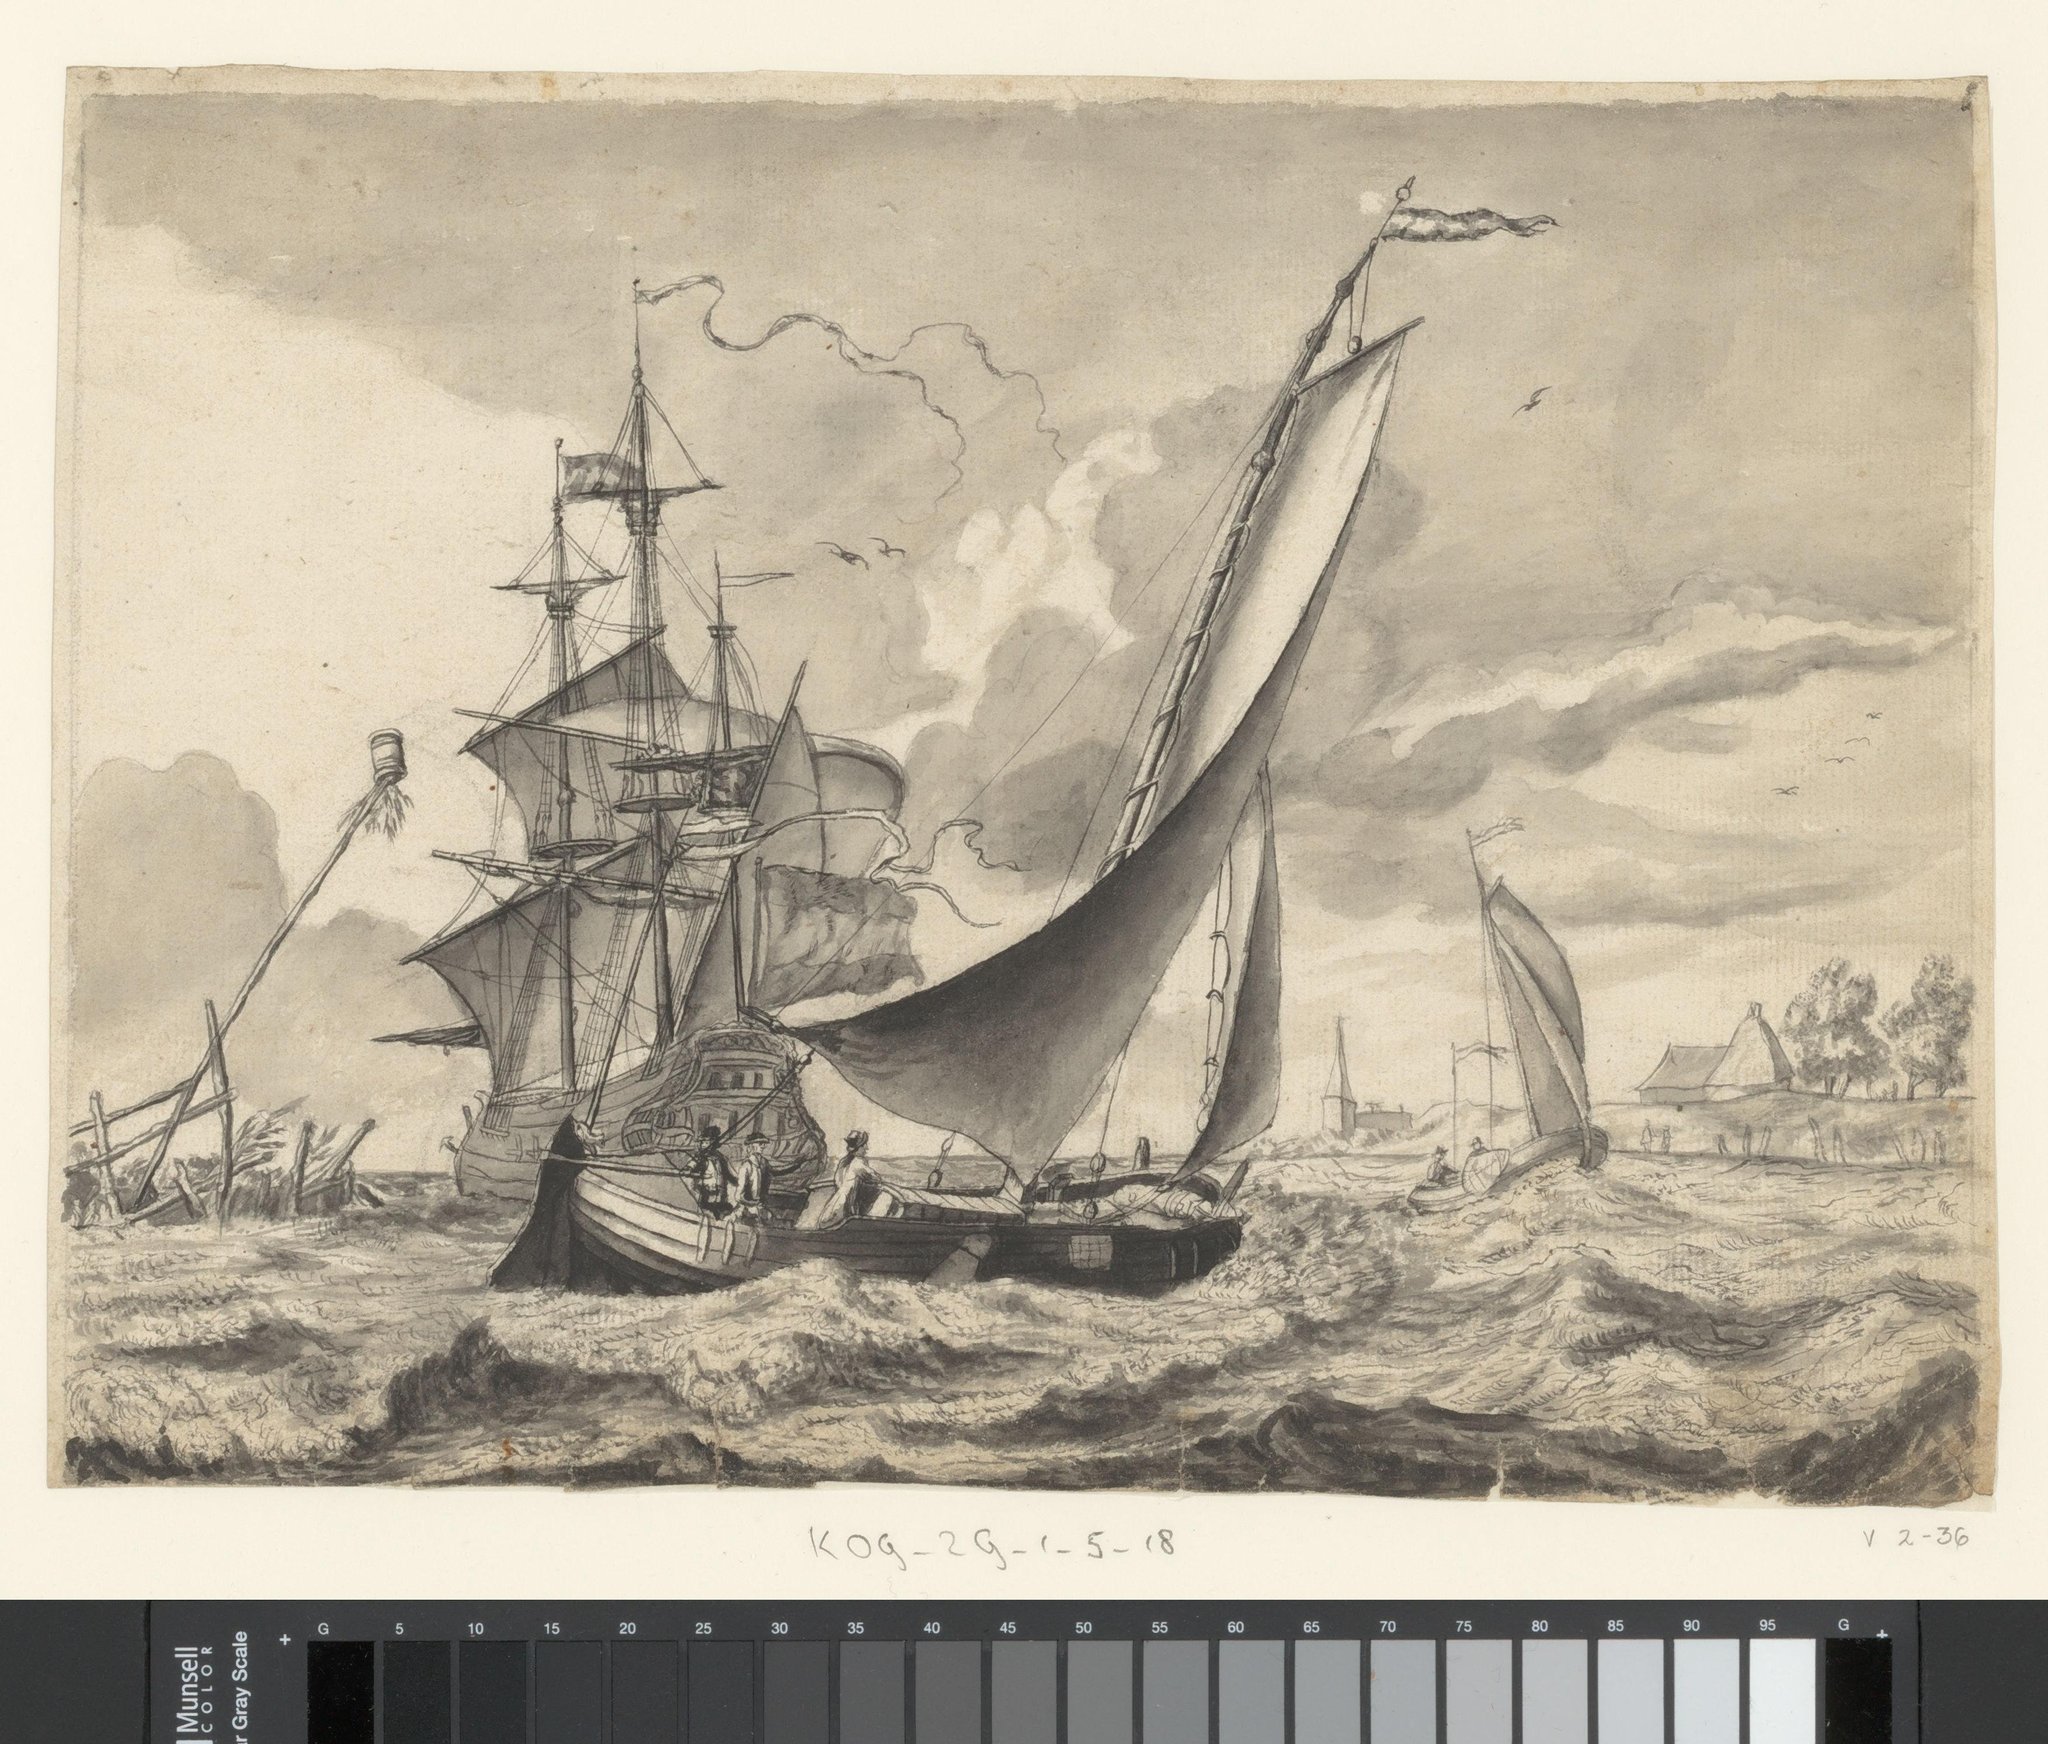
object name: drawing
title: Oorlogsschip op zee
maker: Anonymous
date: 1728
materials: ink, paper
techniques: brush, pen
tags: sailing-ship, sailing-boat, warfare; military affairs (+ naval force)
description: Onderwerpsrubrieken binnen de Atlas Zeden en Gewoonten: Krijgswezen, Zeemacht.